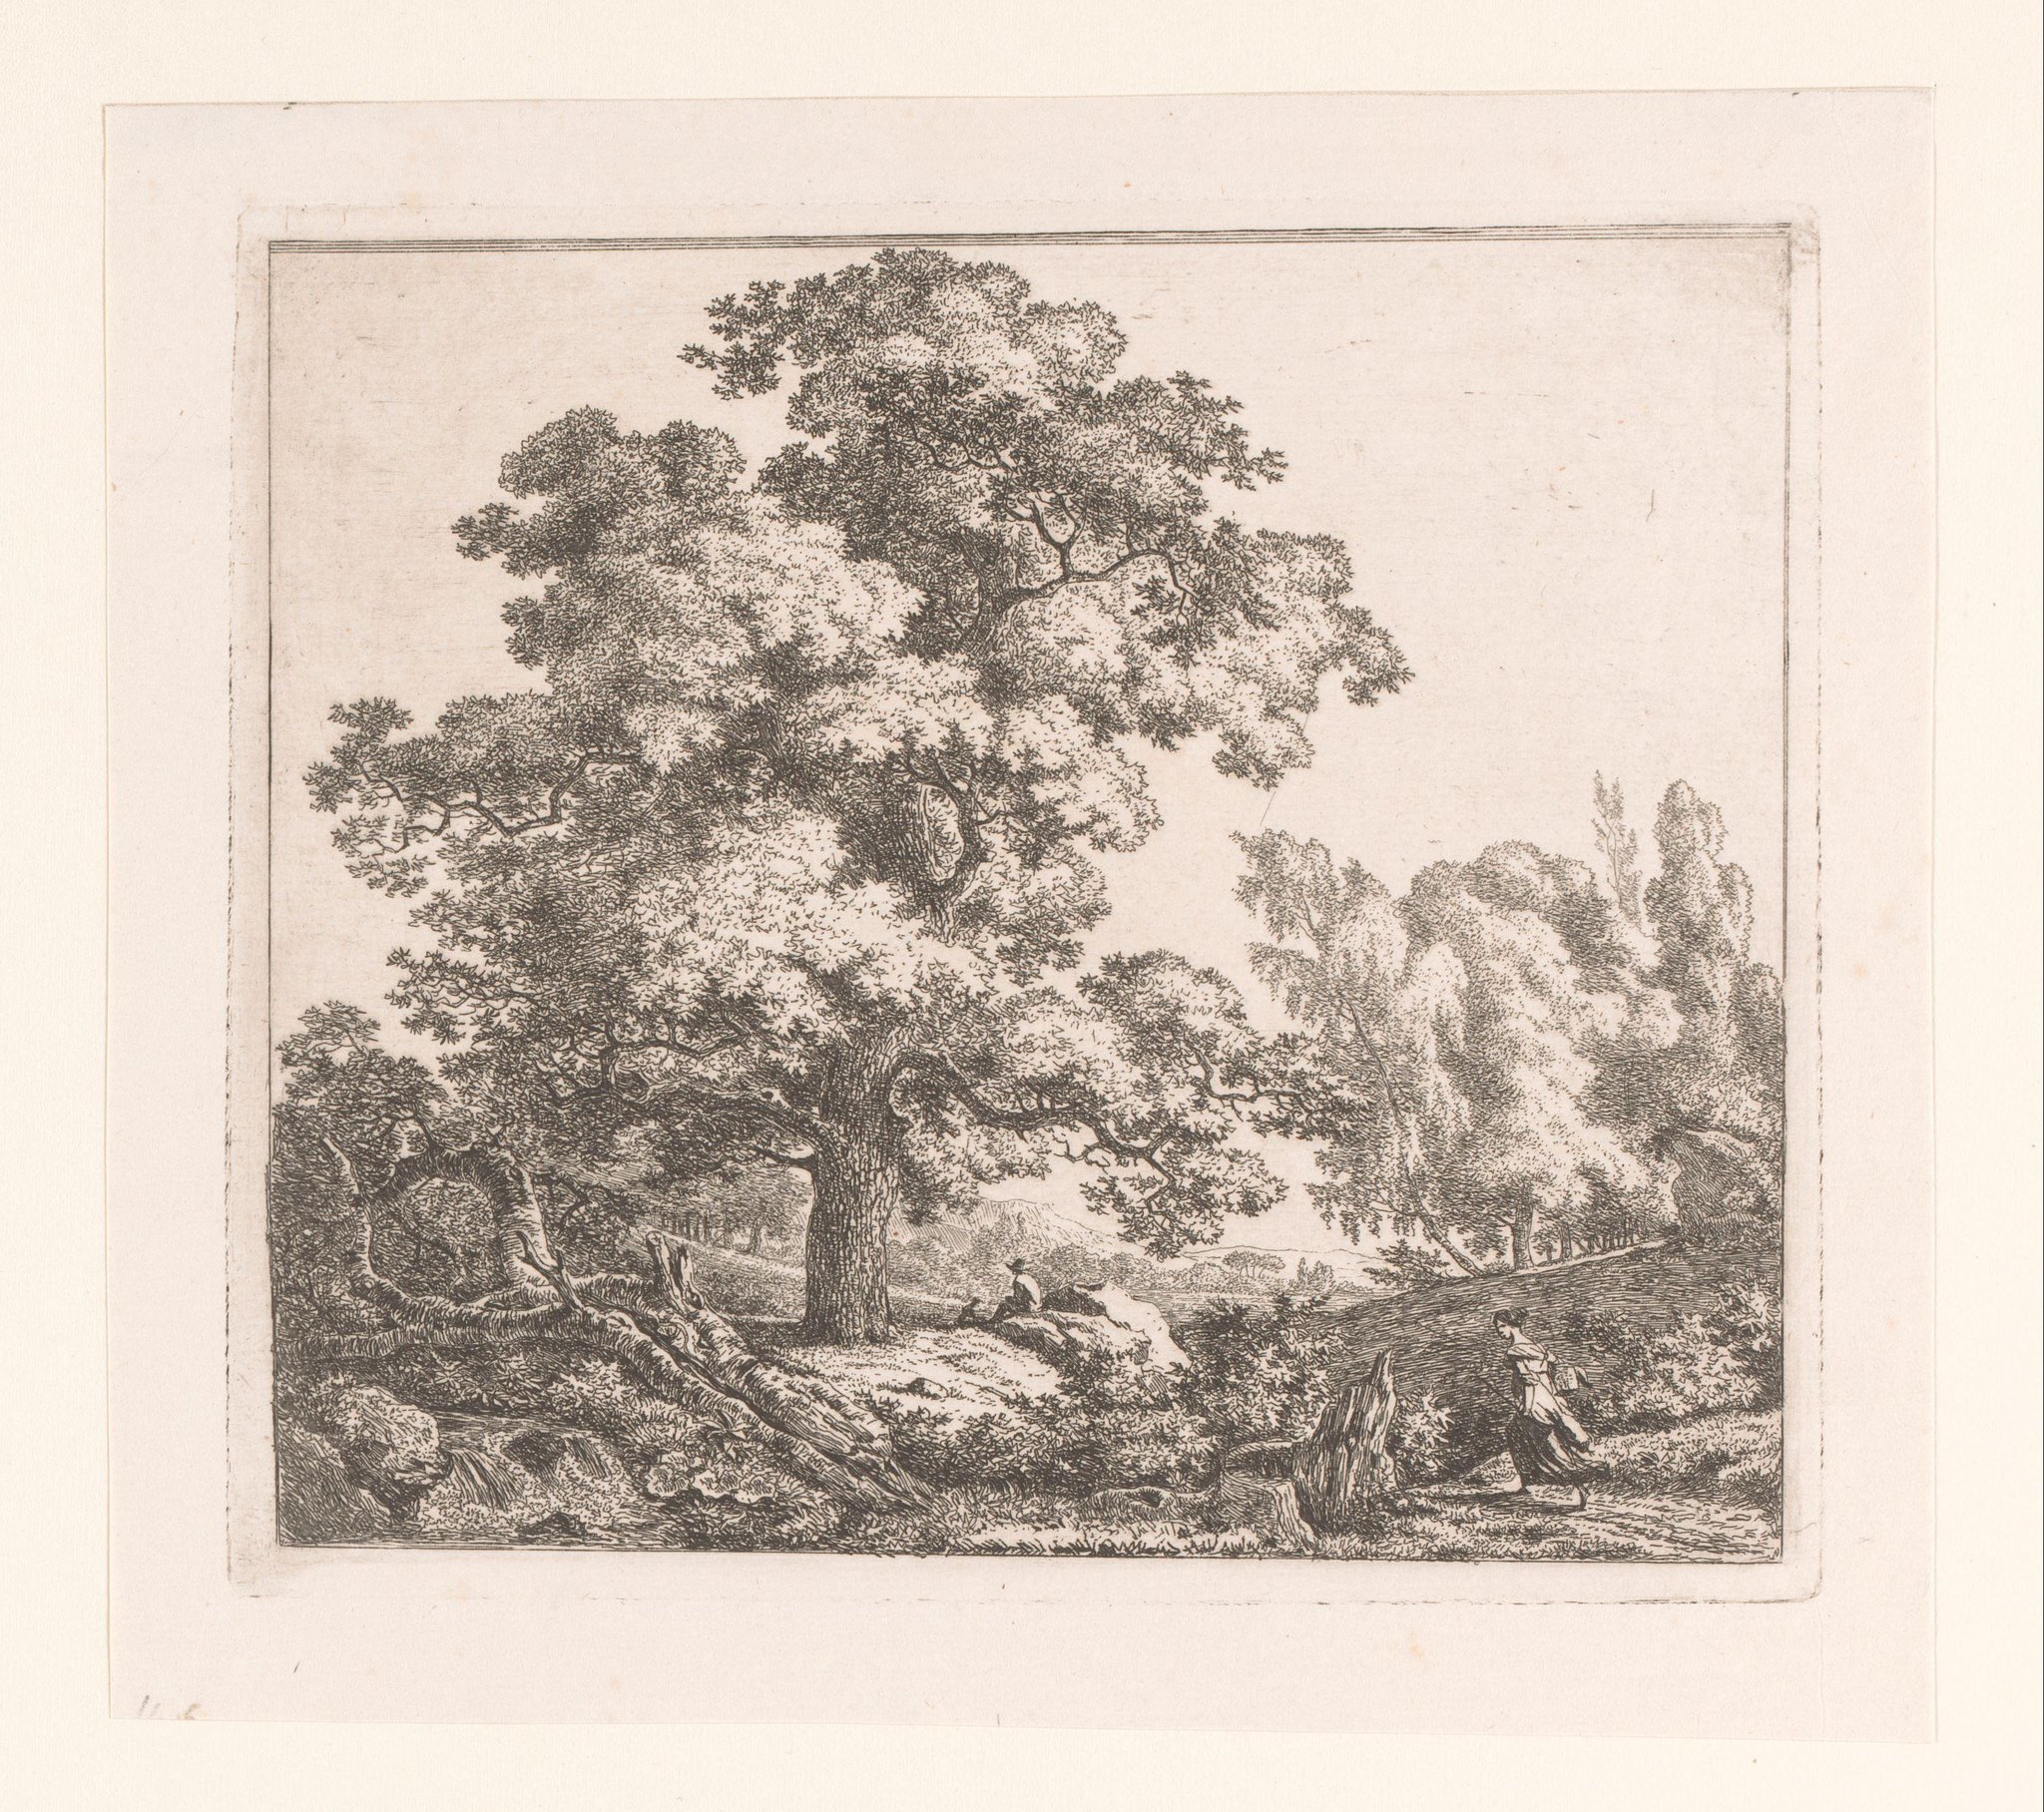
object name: print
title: Landschap met twee figuren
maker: jean louis demarne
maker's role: draughtsman, painter, print maker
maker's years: 1752-1829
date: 1762-1829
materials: paper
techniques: etching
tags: walking - aa - female human figure, landscapes (+ landscape with figures, staffage)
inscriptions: collector's mark: Lugt 2228